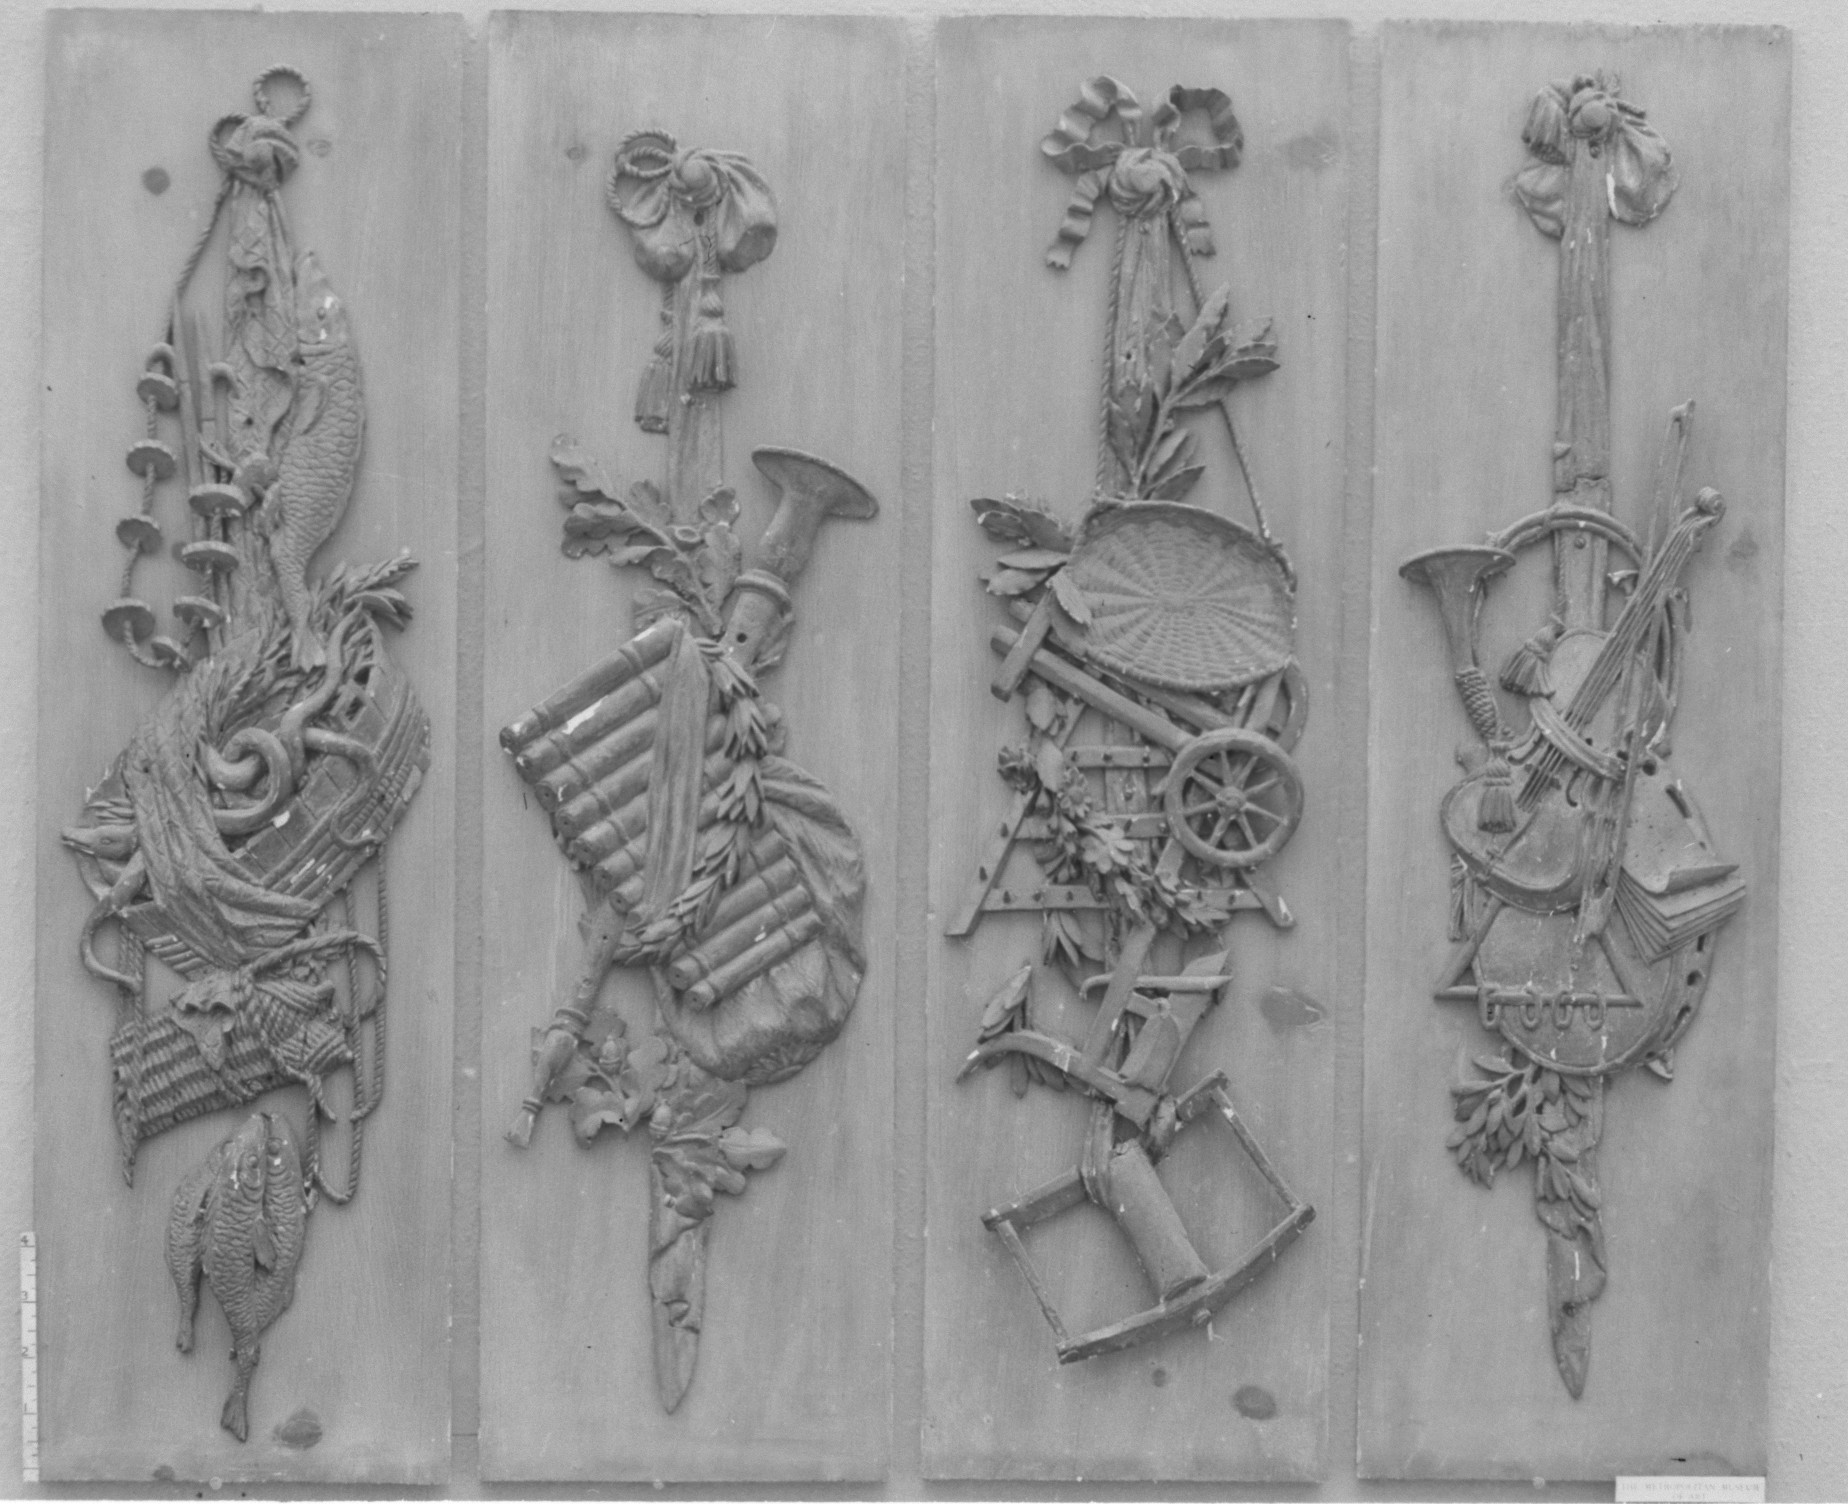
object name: panel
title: Panel (part of a set)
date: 1701-1800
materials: wood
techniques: gilding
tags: musical instruments,fish,leaves